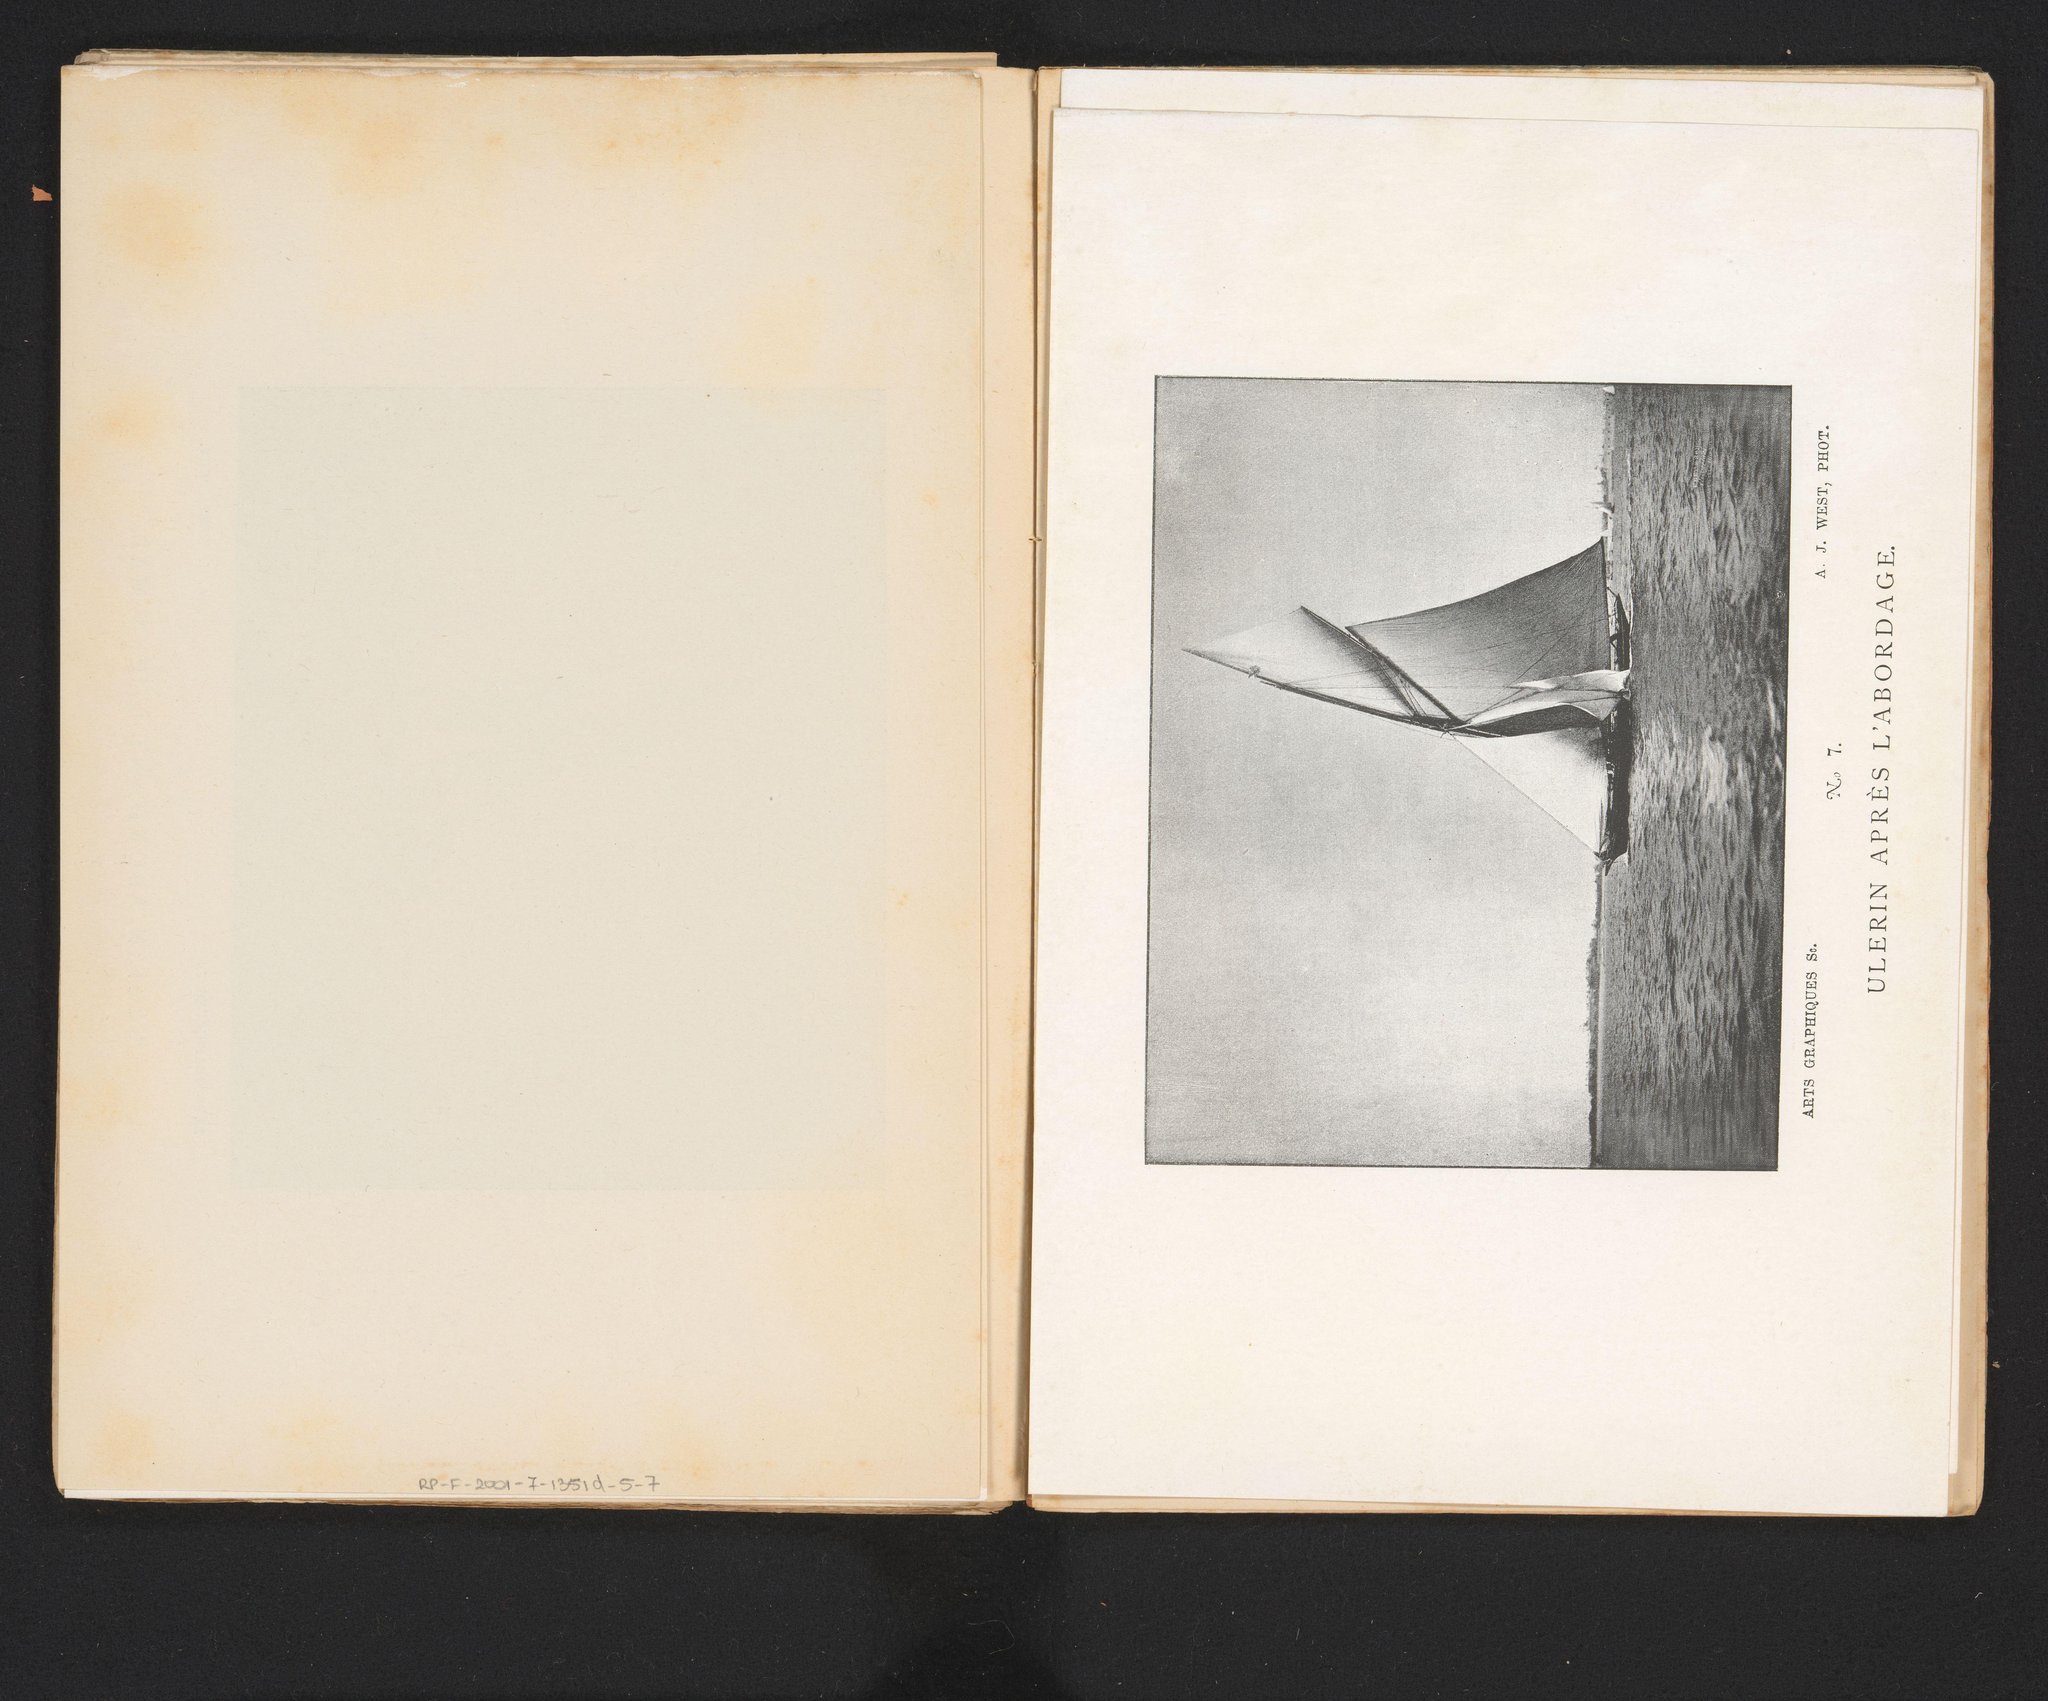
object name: photomechanical print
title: Zeilschip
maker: a.j. west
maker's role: fotograaf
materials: paper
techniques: collo-autotype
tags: sailing-ship, sailing-boat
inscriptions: number: ‘No 7.’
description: Prent op plaat los in boek tussen pagina 254 en 255.